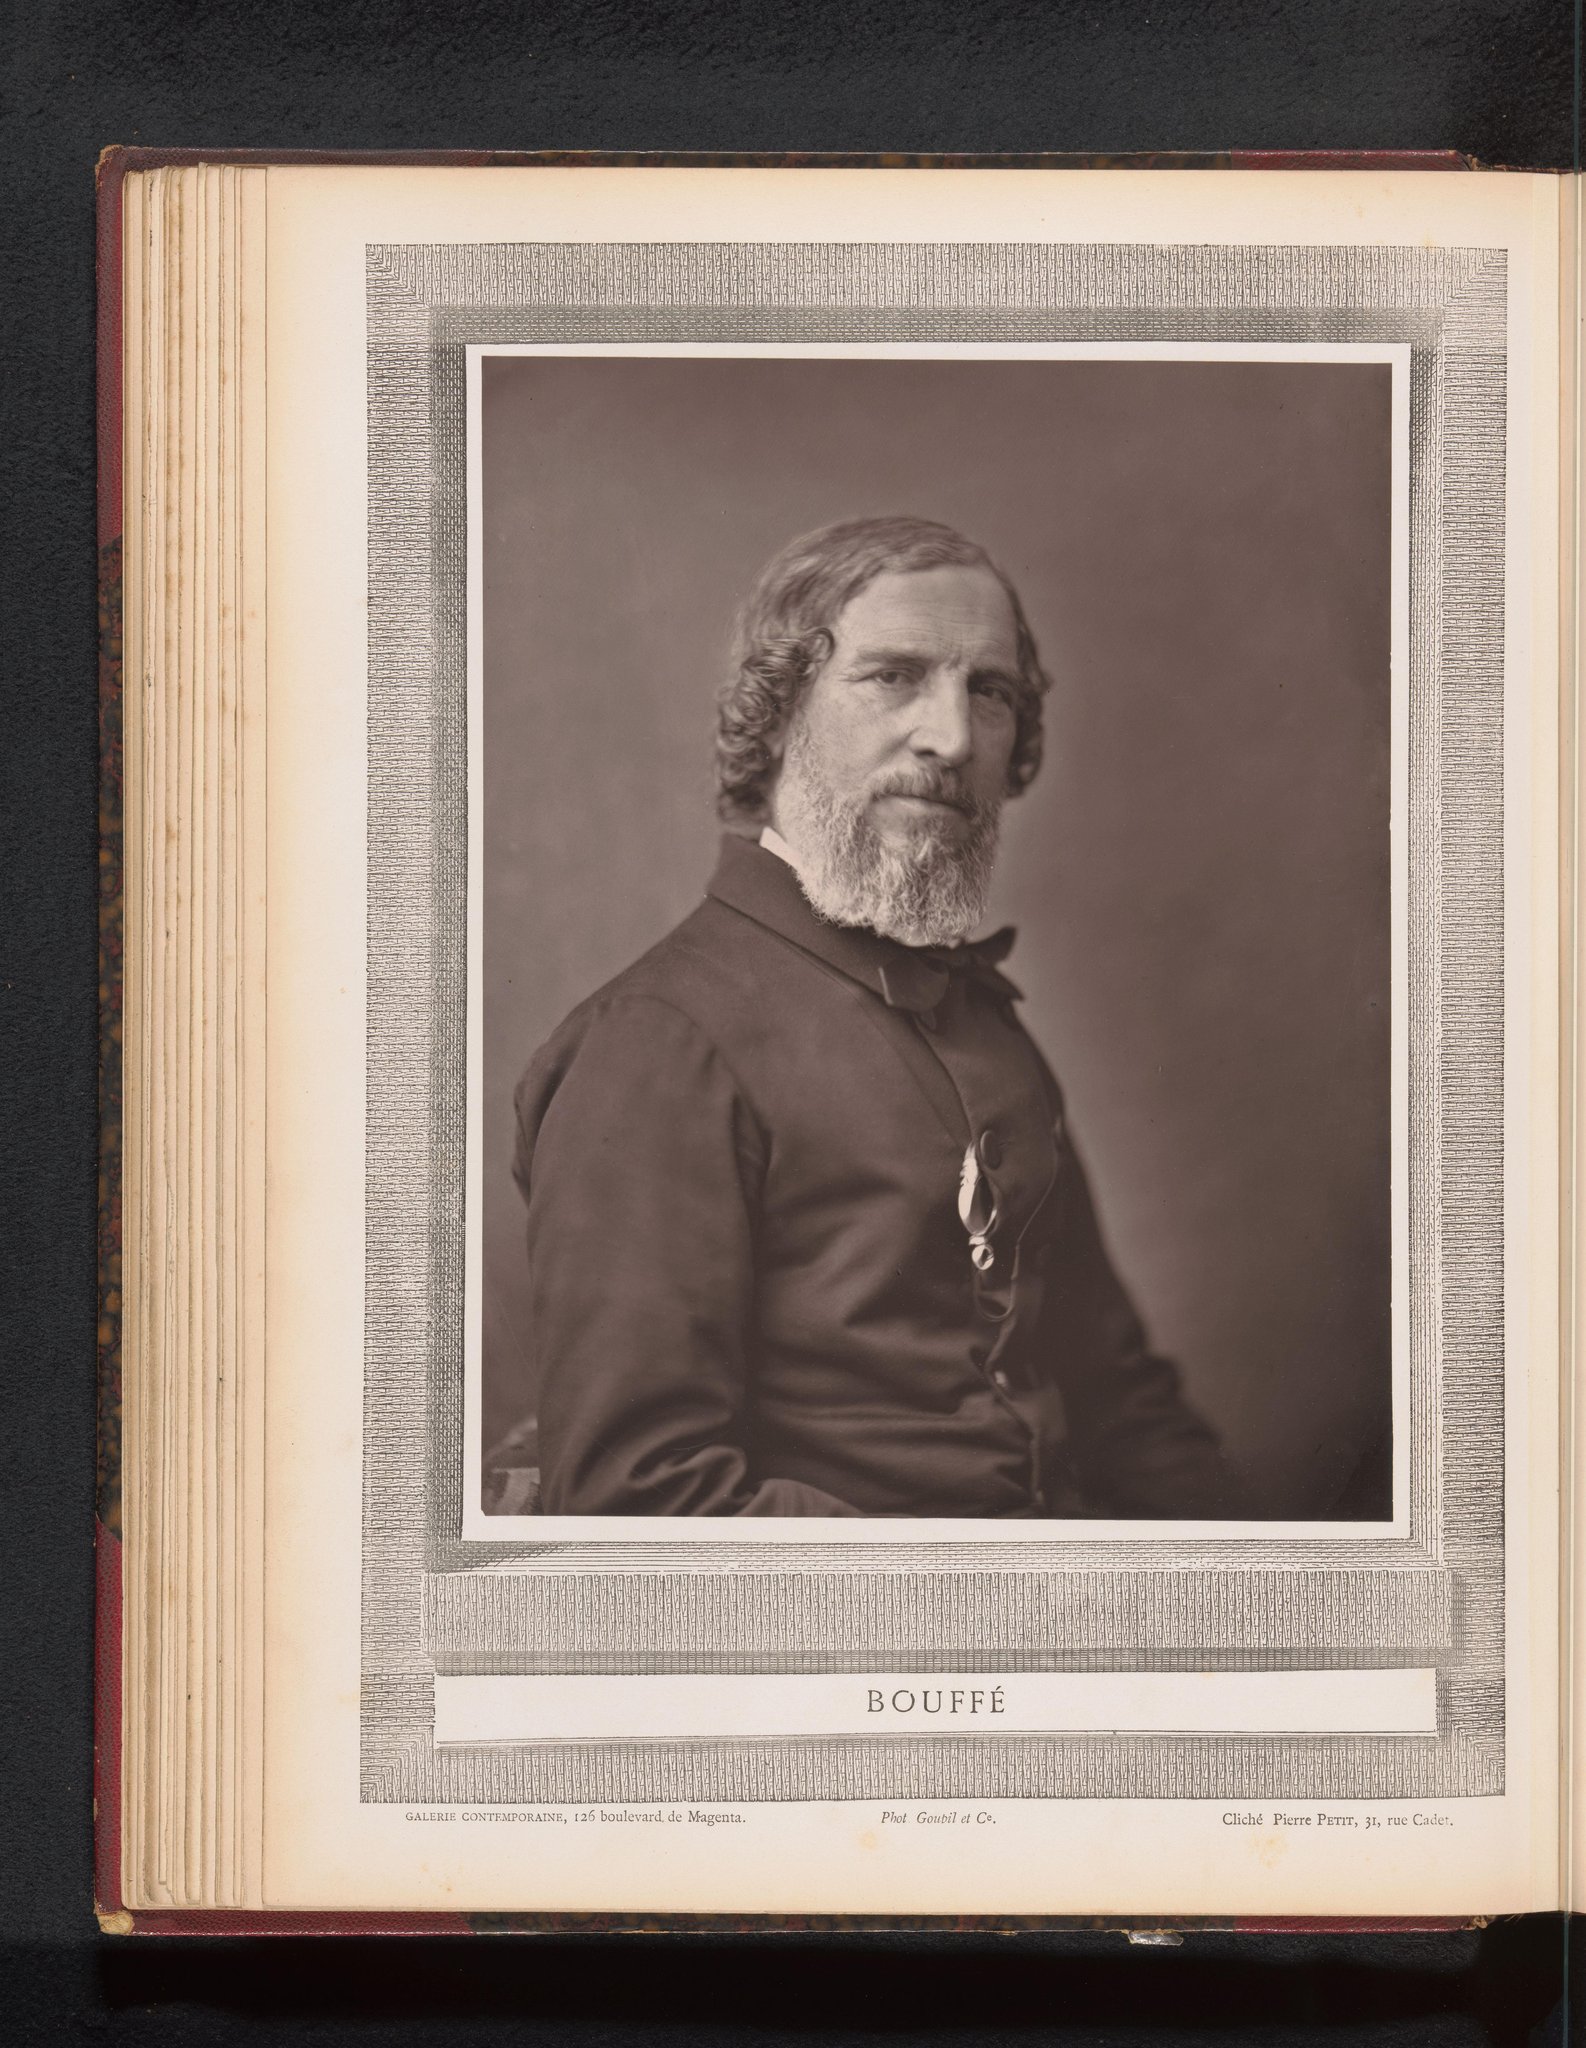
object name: page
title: Portret van Hugues Bouffé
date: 1871-1876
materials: paper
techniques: woodburytype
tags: adult man, historical persons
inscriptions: inscription: ‘Galerie Contemporaine, 126, boulevard de Magenta.’